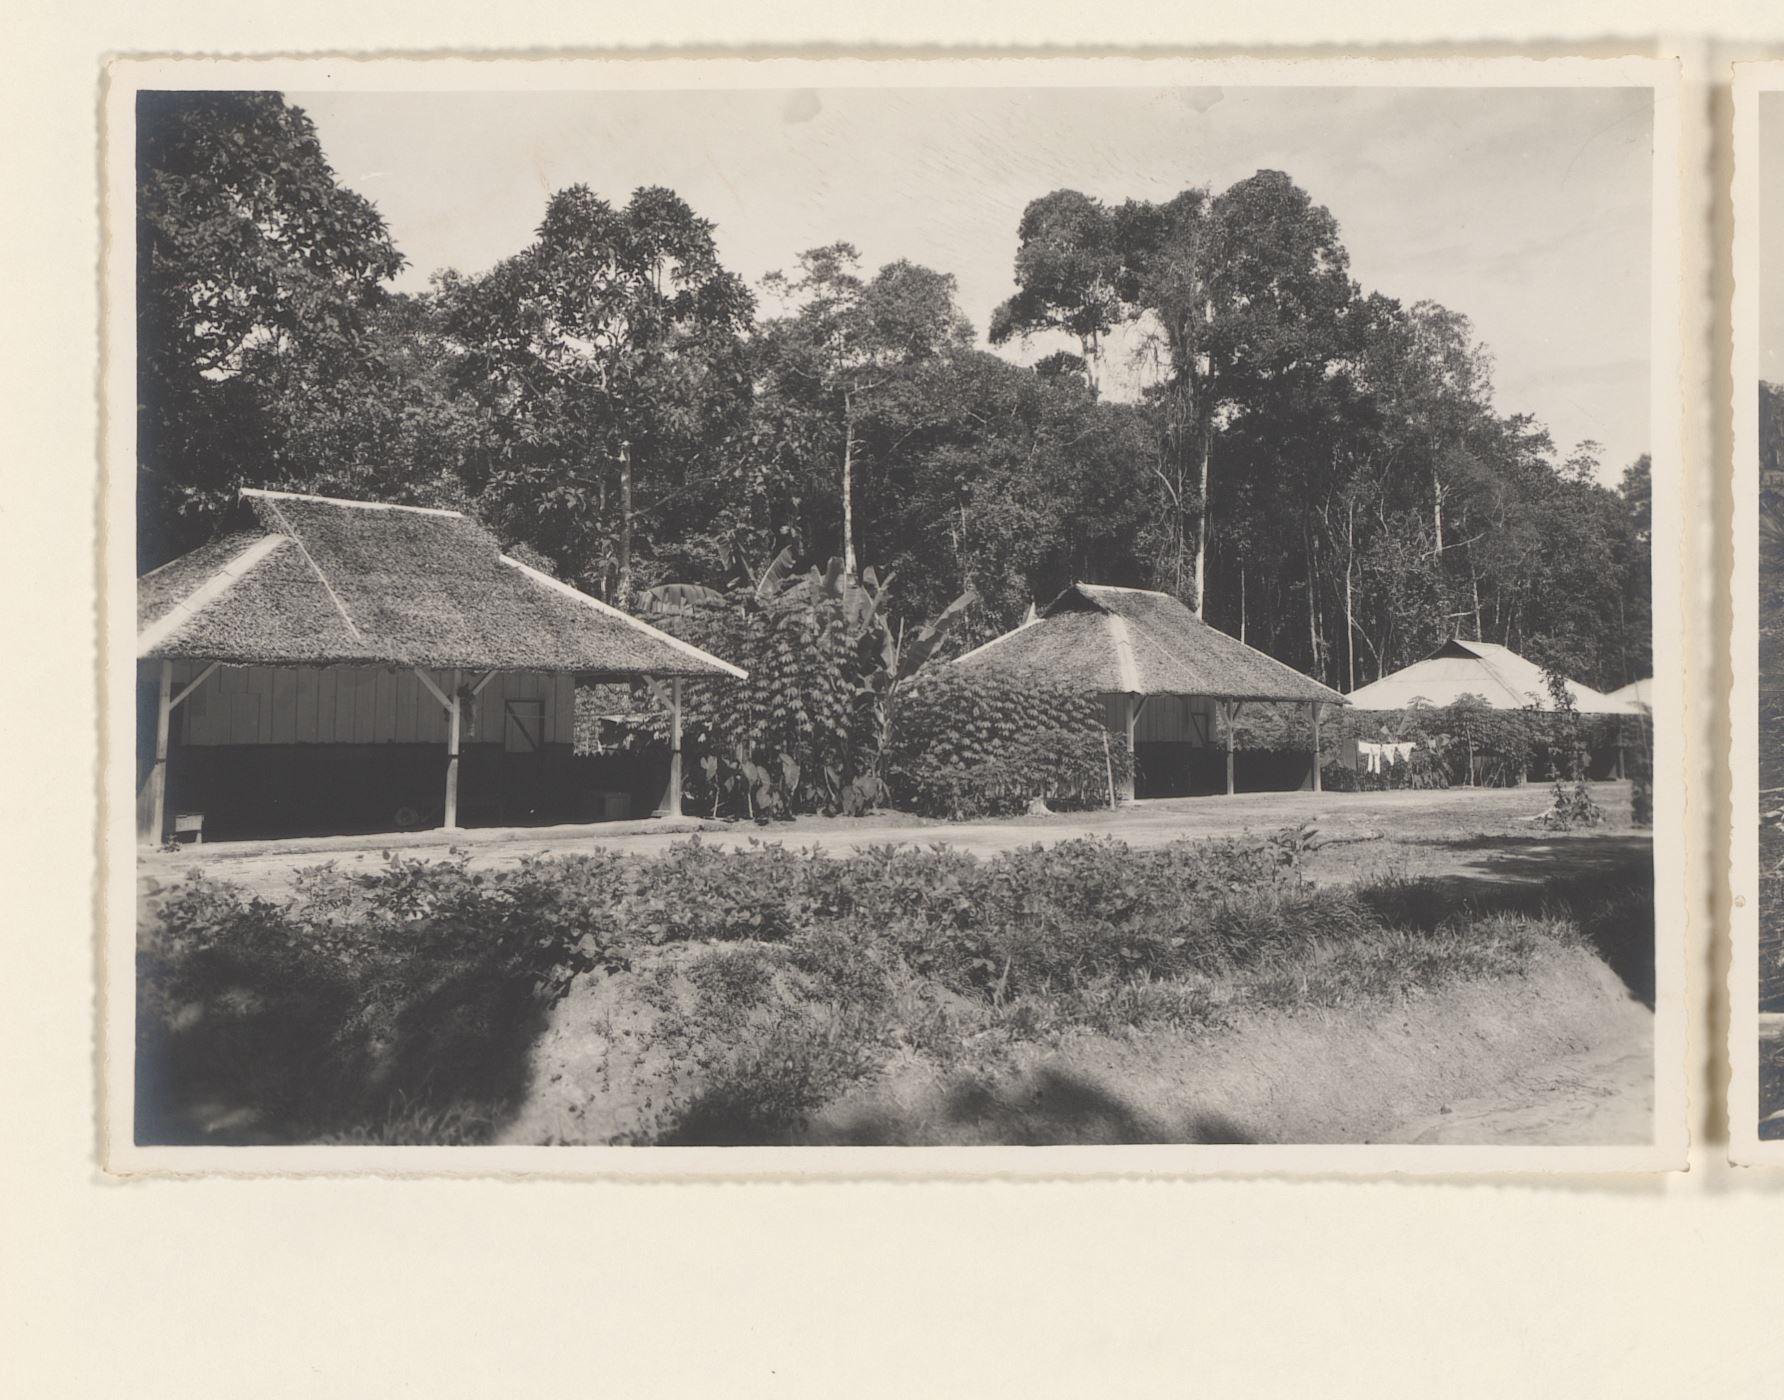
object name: photograph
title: 'Kolonisatiewoningen' op Brussel, 1938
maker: Anonymous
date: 1907-1938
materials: photographic support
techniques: gelatin silver print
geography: sumatra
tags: plantation, (non-fruit) products of plants or trees: rubber, (non-fruit) products of plants or trees: palm oil, hut, cabin, lodge, sumatra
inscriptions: inscription: ‘Kolonisatiewoningen Brussel Juli '38’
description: Zogenaamde 'kolonisatiewoningen' op de plantage Brussel, juli 1938. Tweede afdruk, los in melinexhoesje, van een foto ingeplakt op albumblad 8. Onderdeel van het fotoalbum over de plantages Pernantian en Brussel van de Sumatra Caoutchouc Maatschappij op de Oostkust van Sumatra in de jaren 1935-1939.